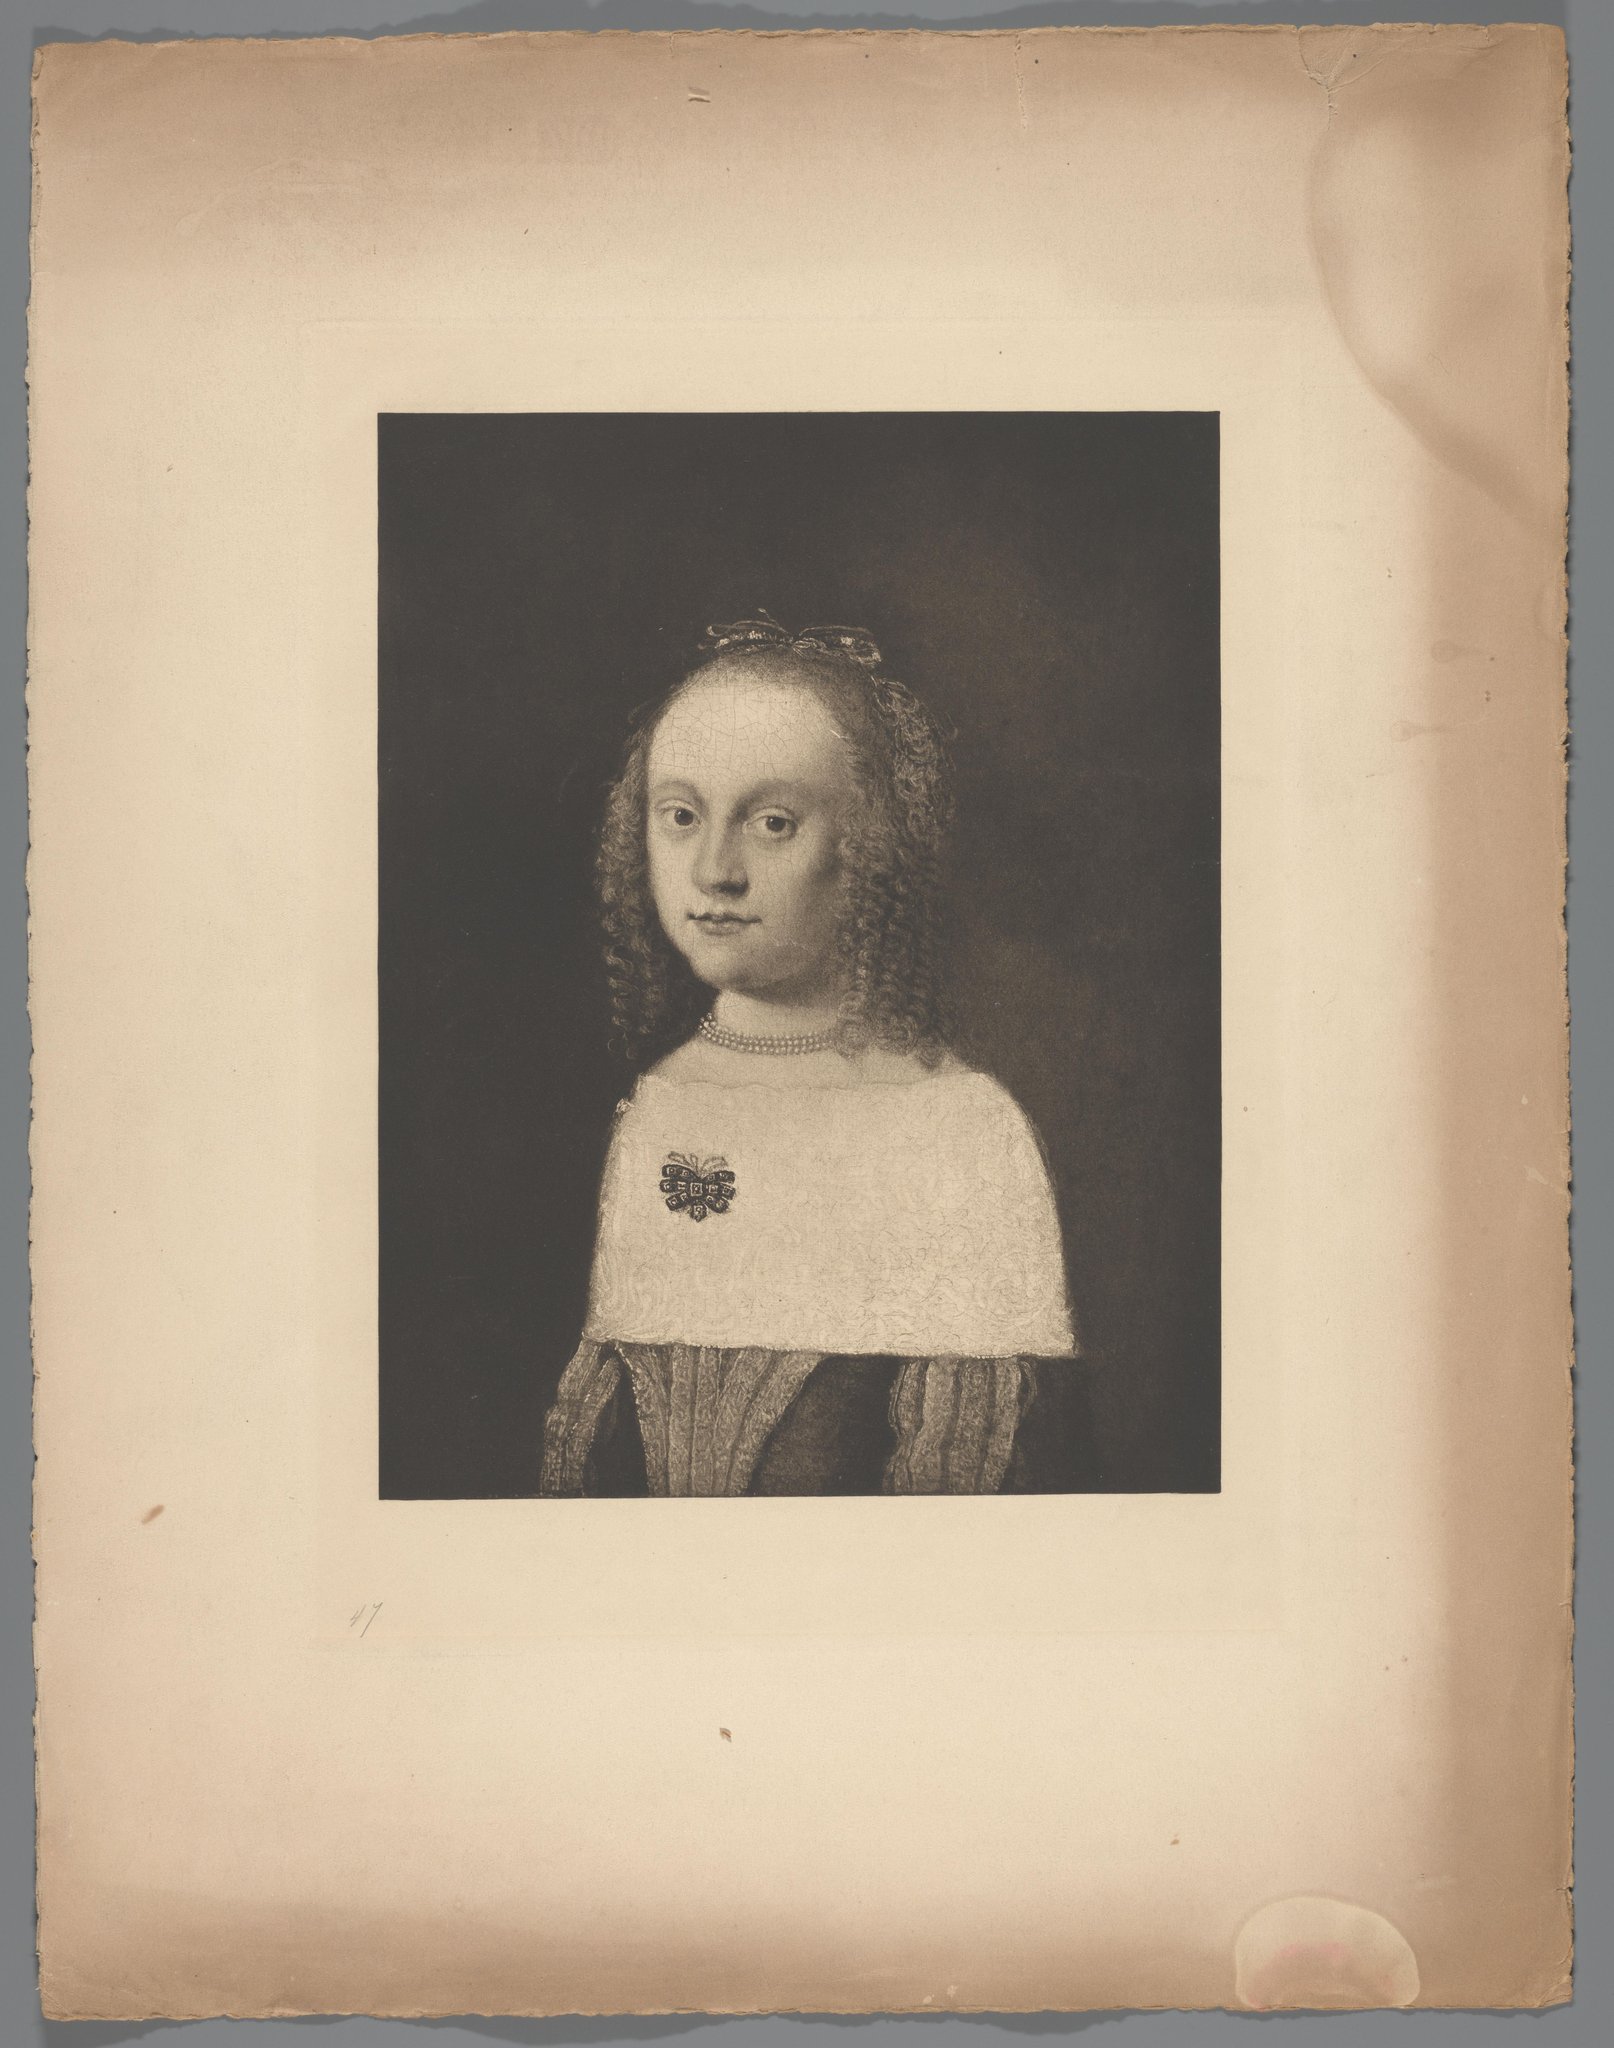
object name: photomechanical print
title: Reproductie van het schilderij Portret van een jong meisje door een imitator van Johannes Vermeer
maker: Anonymous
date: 1880-2023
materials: paper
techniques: photoaquatint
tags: adolescent, young woman, maiden, anonymous historical person portrayed alone - bb - woman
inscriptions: number: ‘47’